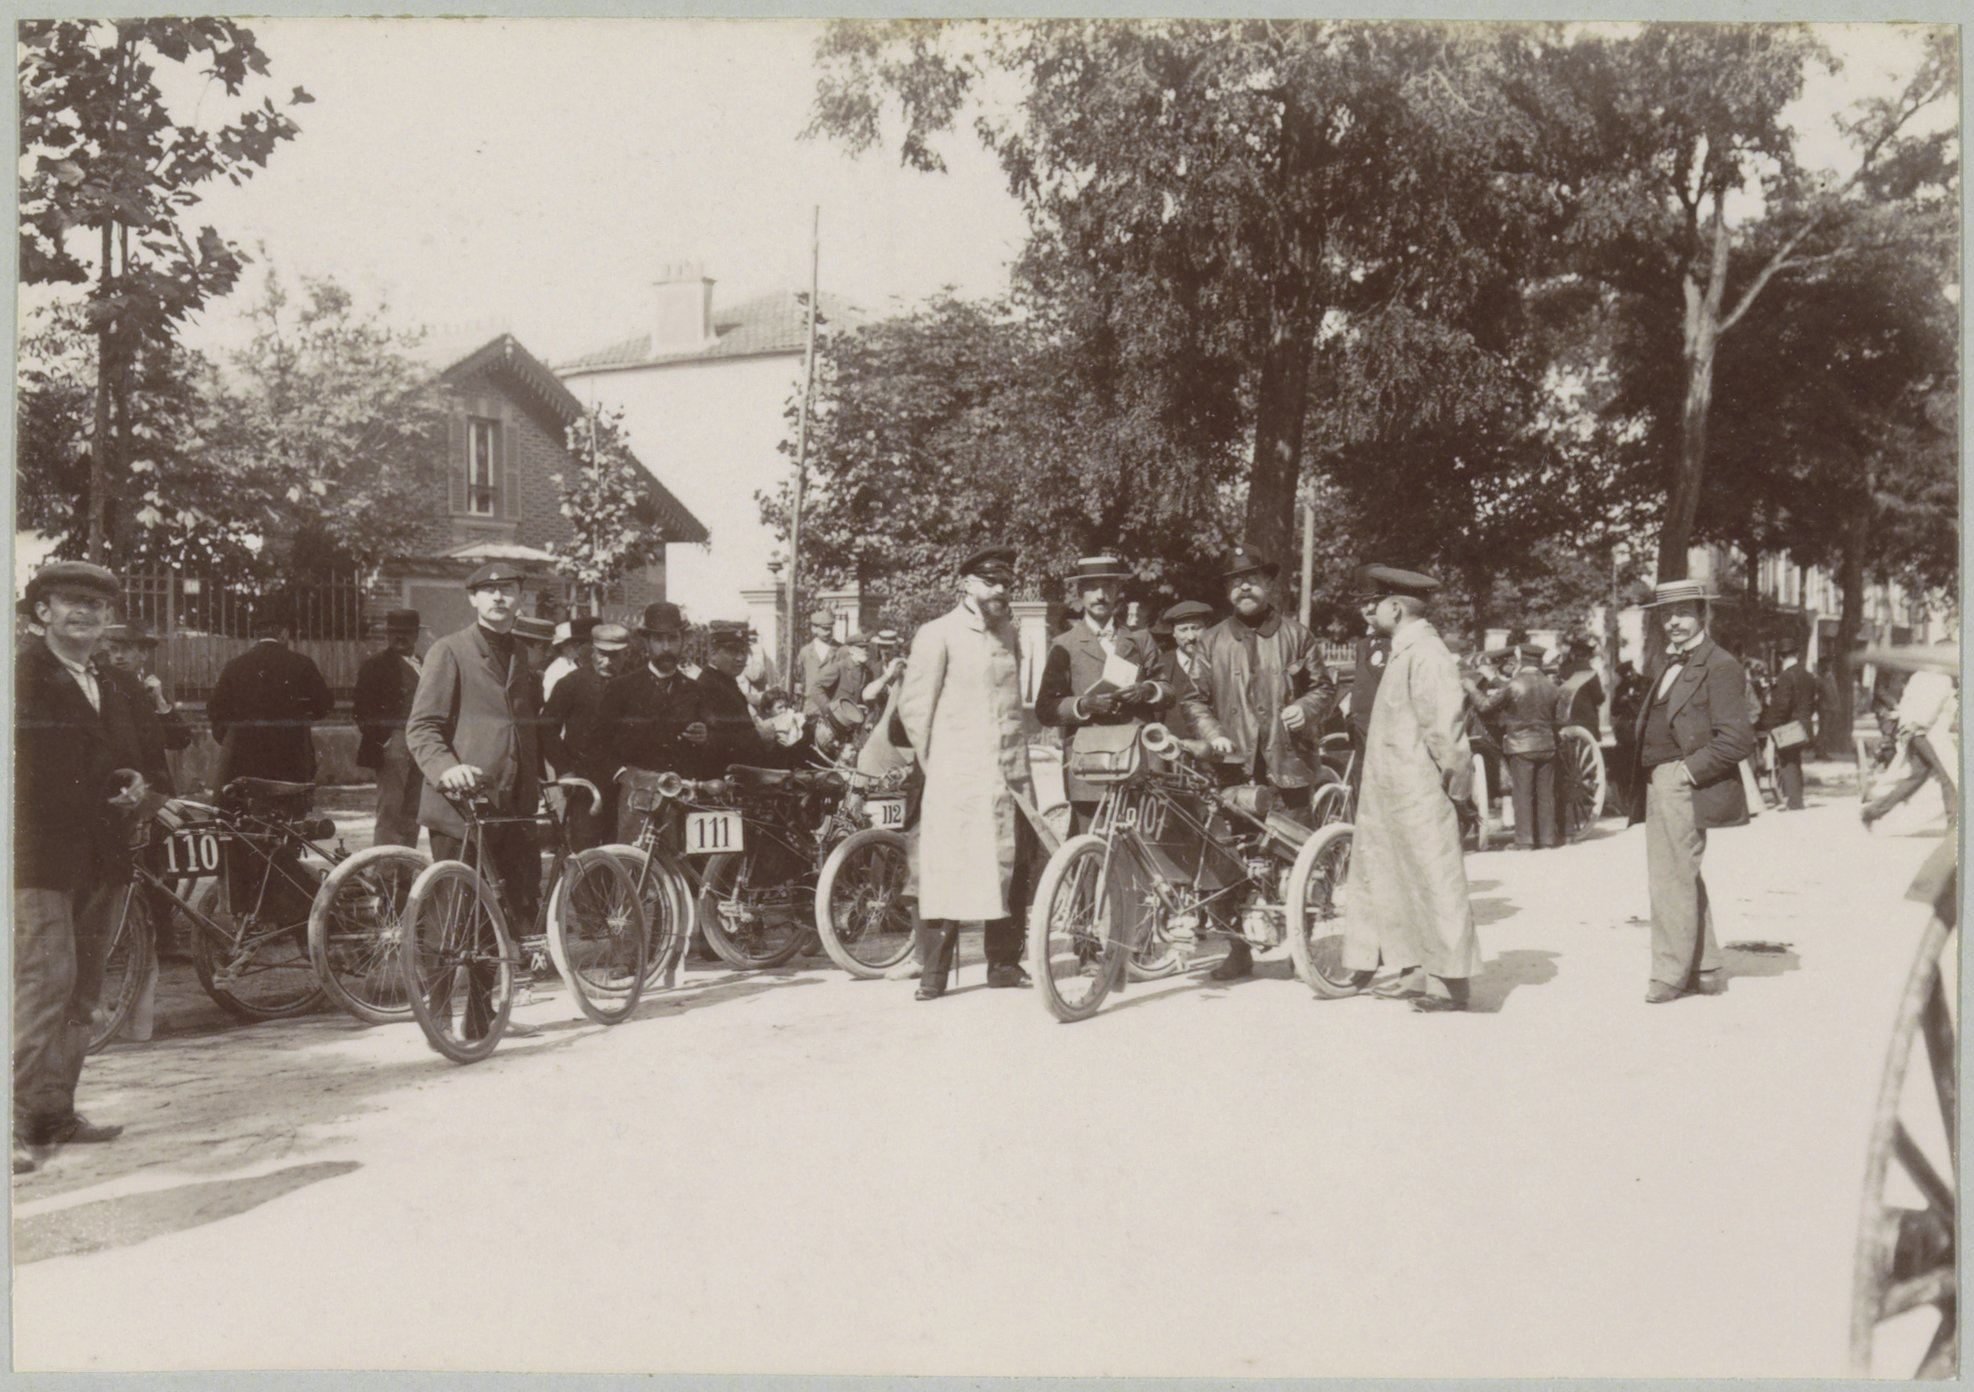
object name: photograph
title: Start van de race Parijs-Amsterdam voor automobielen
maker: delizy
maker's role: manufacturer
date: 1898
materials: paper, photographic support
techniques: collodion silver print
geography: paris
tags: motorcar racing, automobile, street (+ city(-scape) with figures, staffage), paris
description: Onderdeel van Fotoalbum van een Franse amateurfotograaf met opnames van uitstapjes in Frankrijk, Spanje, België, Luxemburg en Nederland, de eerste automobielen en autoraces.